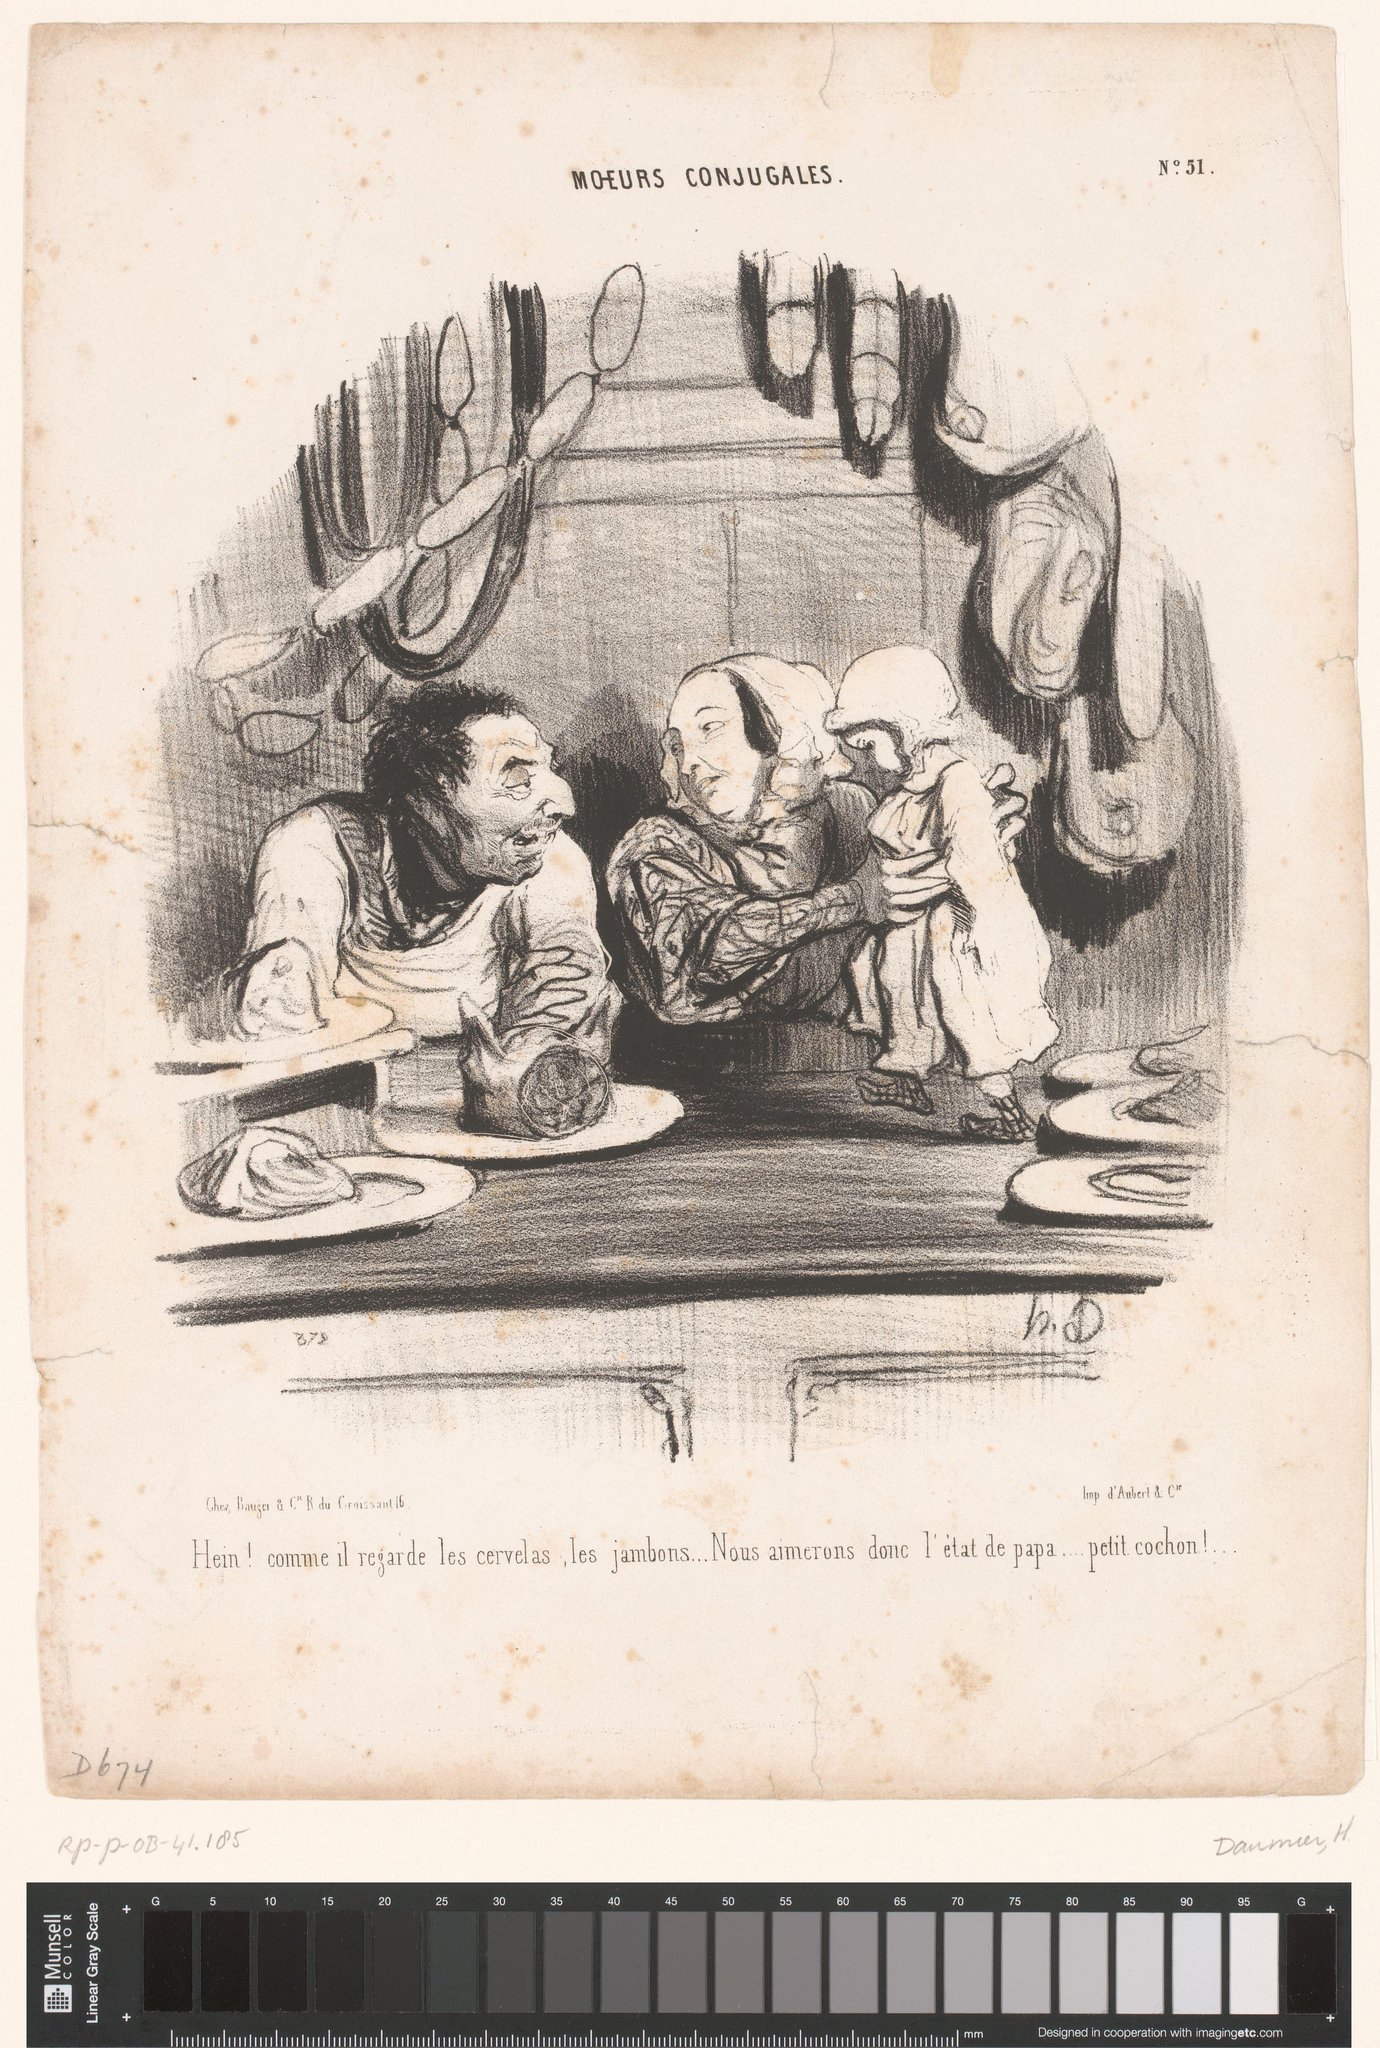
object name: cartoon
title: Hein! Comme il regarde les cervelas (...)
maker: honoré daumier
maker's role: draughtsman, painter, print maker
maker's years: 1808-1879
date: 1842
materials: paper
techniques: lithograph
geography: paris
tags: parents with their children, caricatures (human types), male infant, butcher, slaughterman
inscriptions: collector's mark: Lugt 2228a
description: Prent gebruikt voor: Le Charivari, 8 mei 1842.